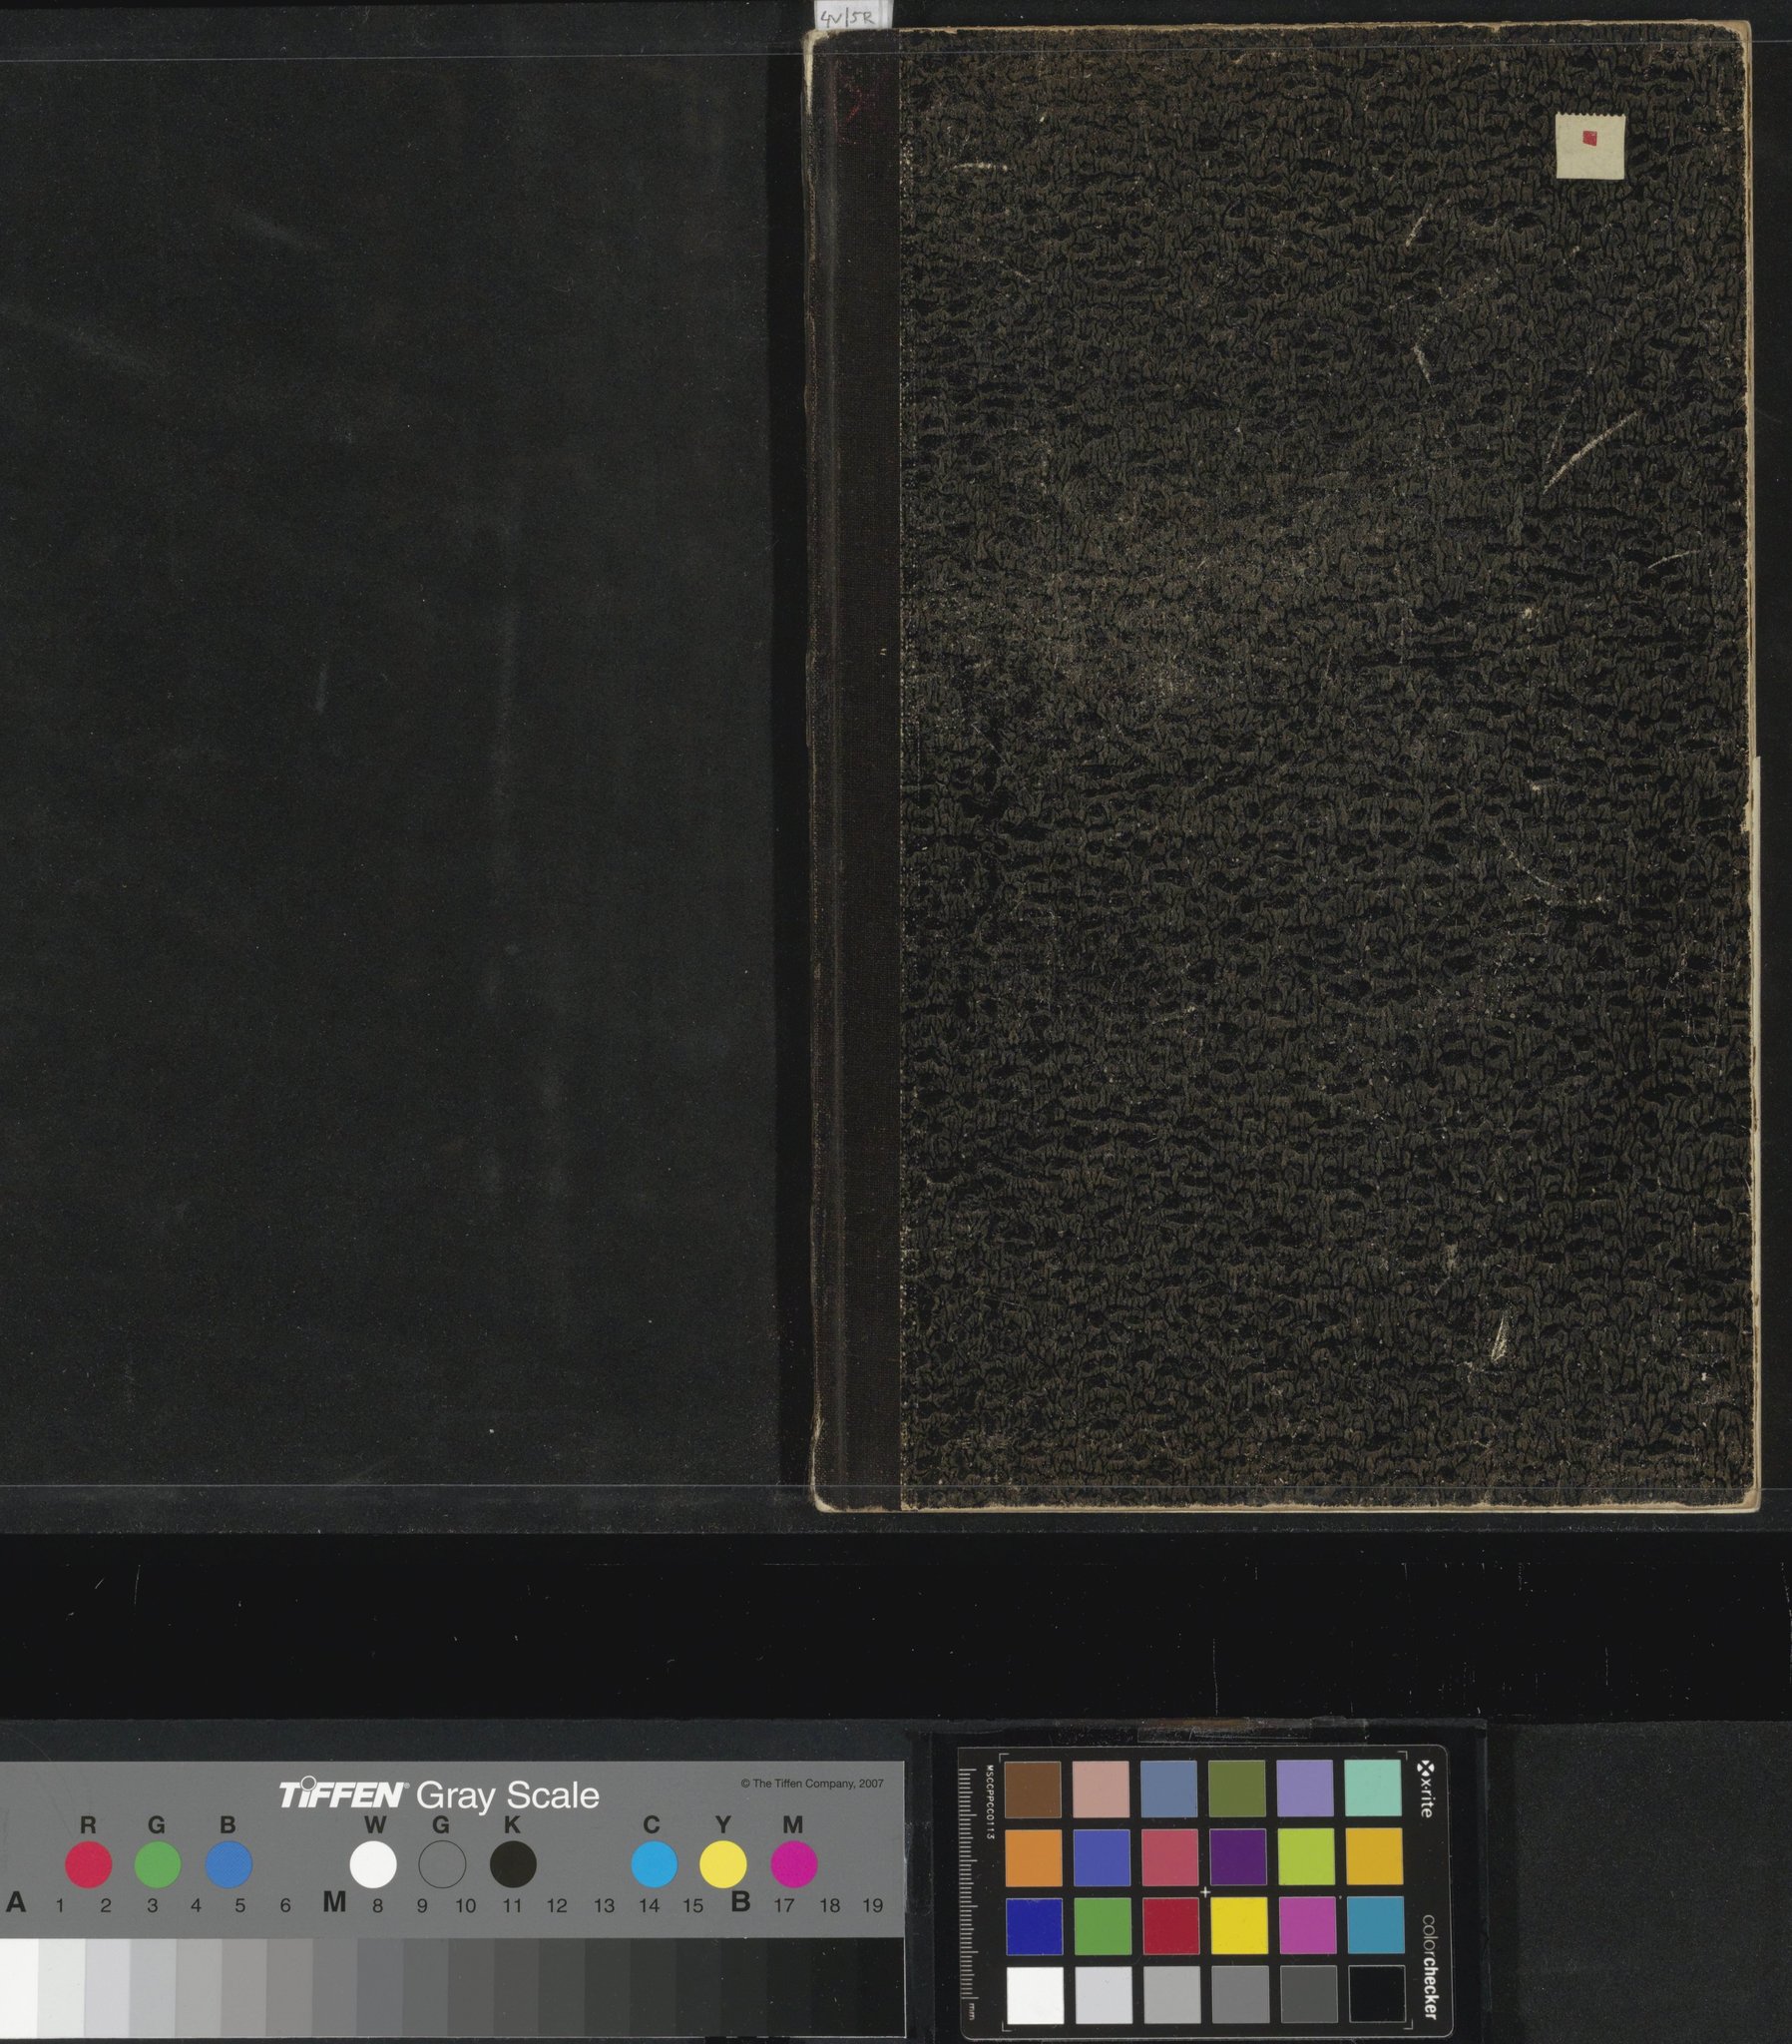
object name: sketchbook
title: Schetsboek met 55 bladen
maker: willem bastiaan tholen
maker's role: draughtsman, painter, print maker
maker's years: 1860-1931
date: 1900-1931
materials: cardboard, chalk, pencil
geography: enkhuizen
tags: city-view, and landscape with man-made constructions, sailing-ship, sailing-boat, landscapes with waters, waterscapes, seascapes (in the temperate zone), windmill in landscape, enkhuizen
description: Schetsboek in de vorm van een folioschrift bestaande uit 55 bladen met voornamelijk landschappen met water en molens, stadsgezichten in en om Enkhuizen, zeilschepen en figuren.